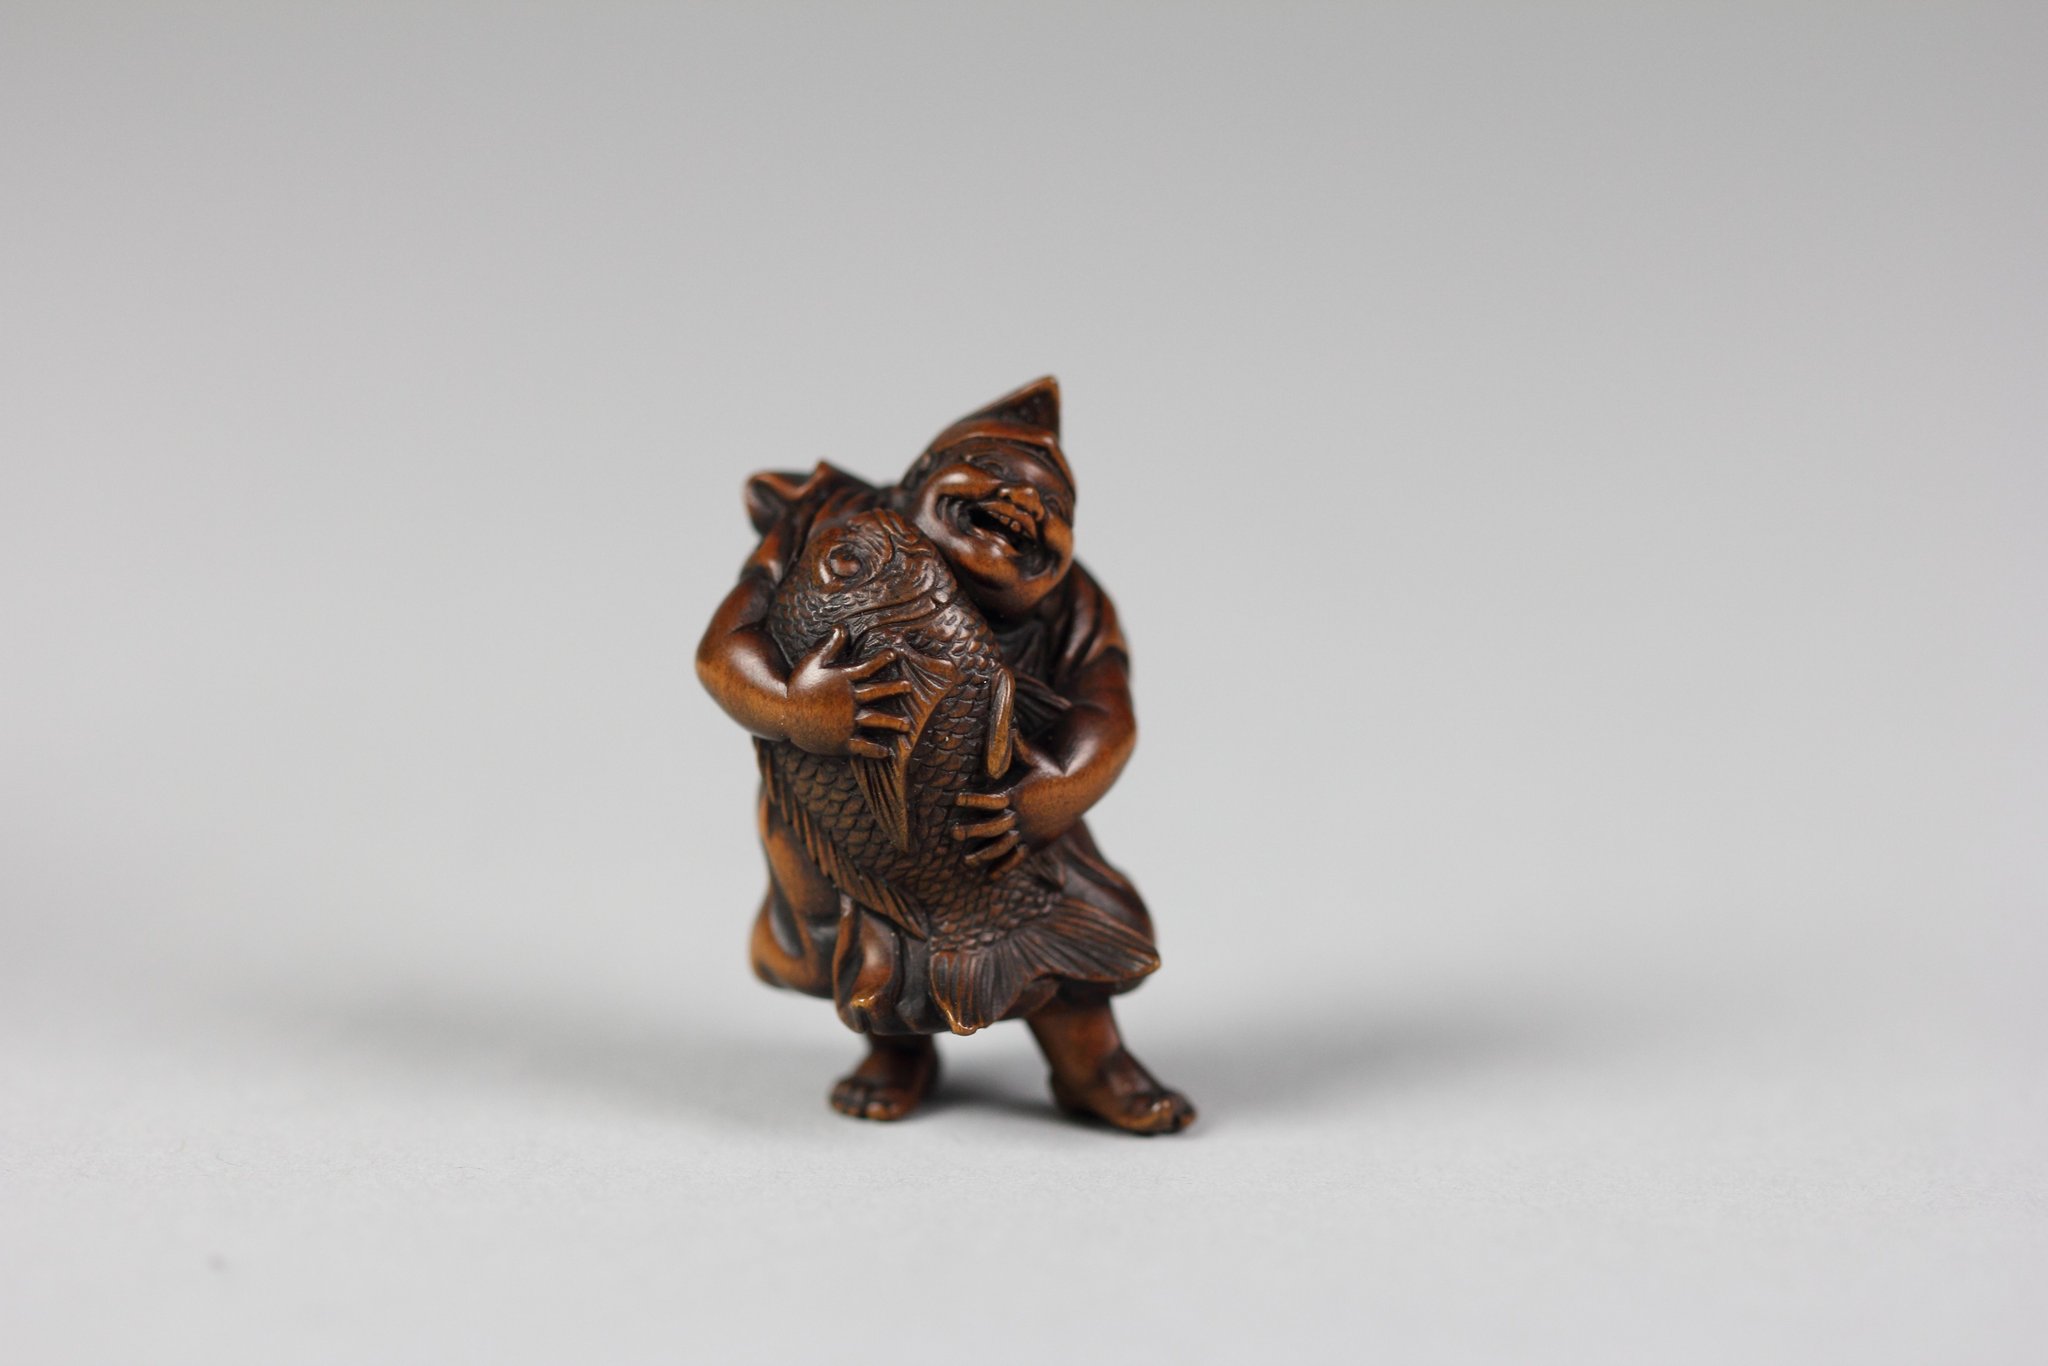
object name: netsuke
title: Netsuke of Ebisu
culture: japanese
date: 1801-1900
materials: wood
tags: men,fish